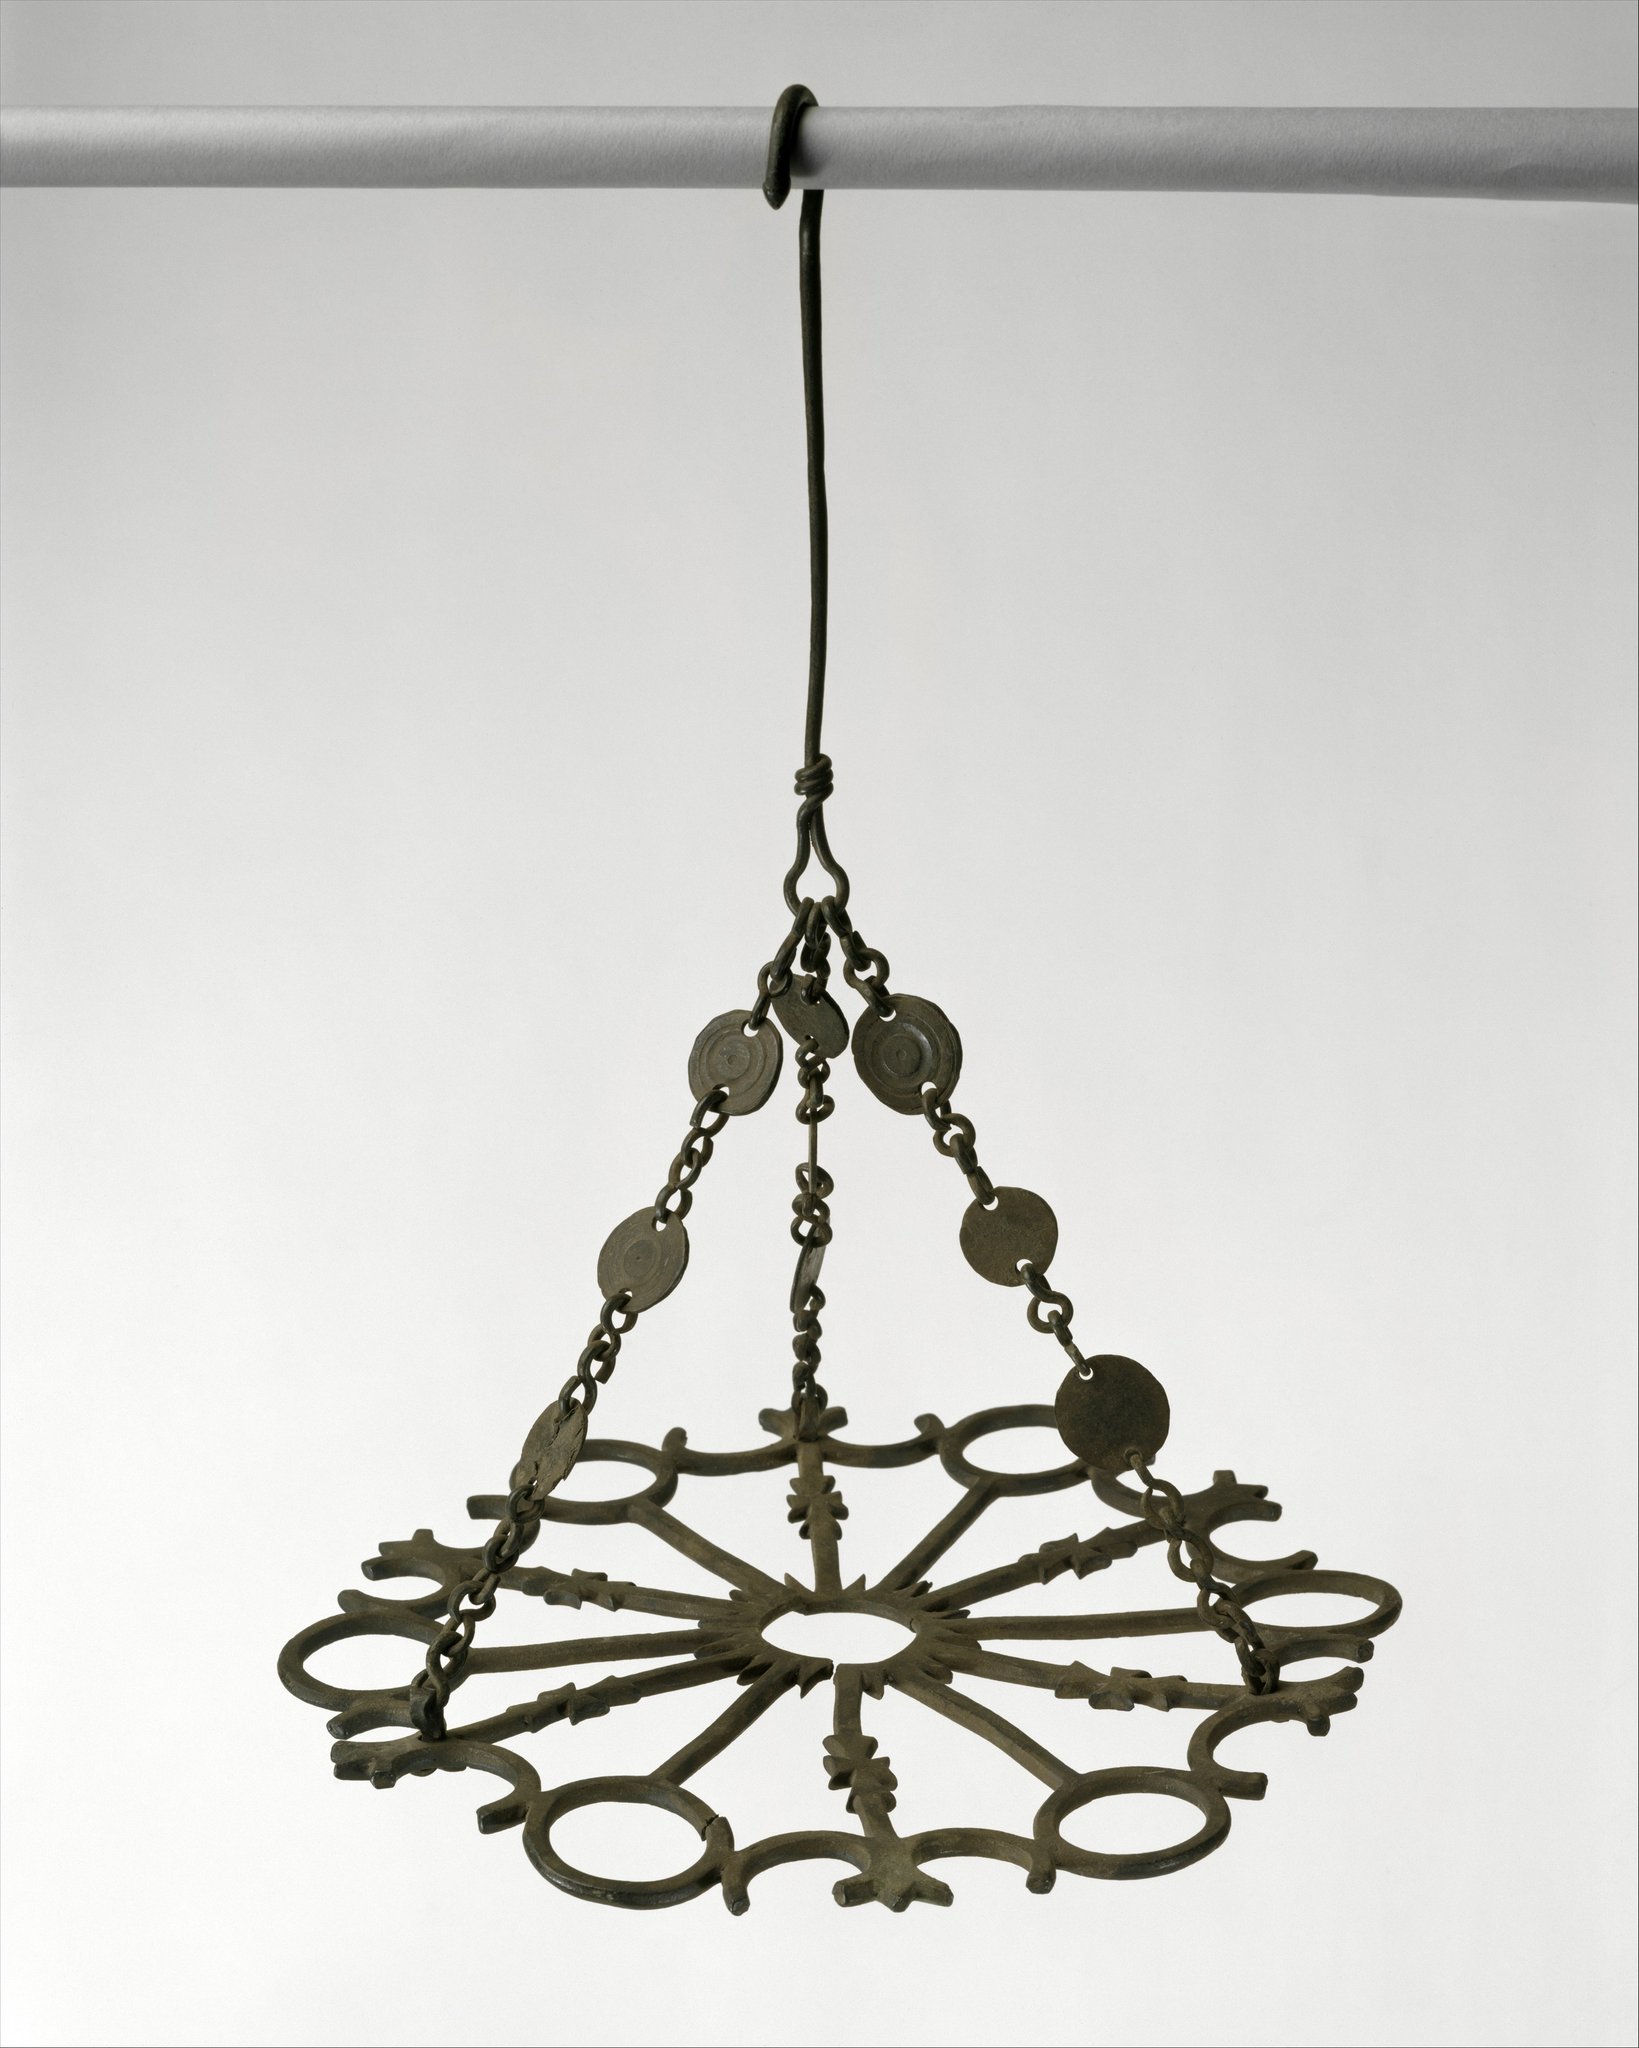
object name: polycandelon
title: Polycandelon with Crosses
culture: byzantine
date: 500-700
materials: copper alloy